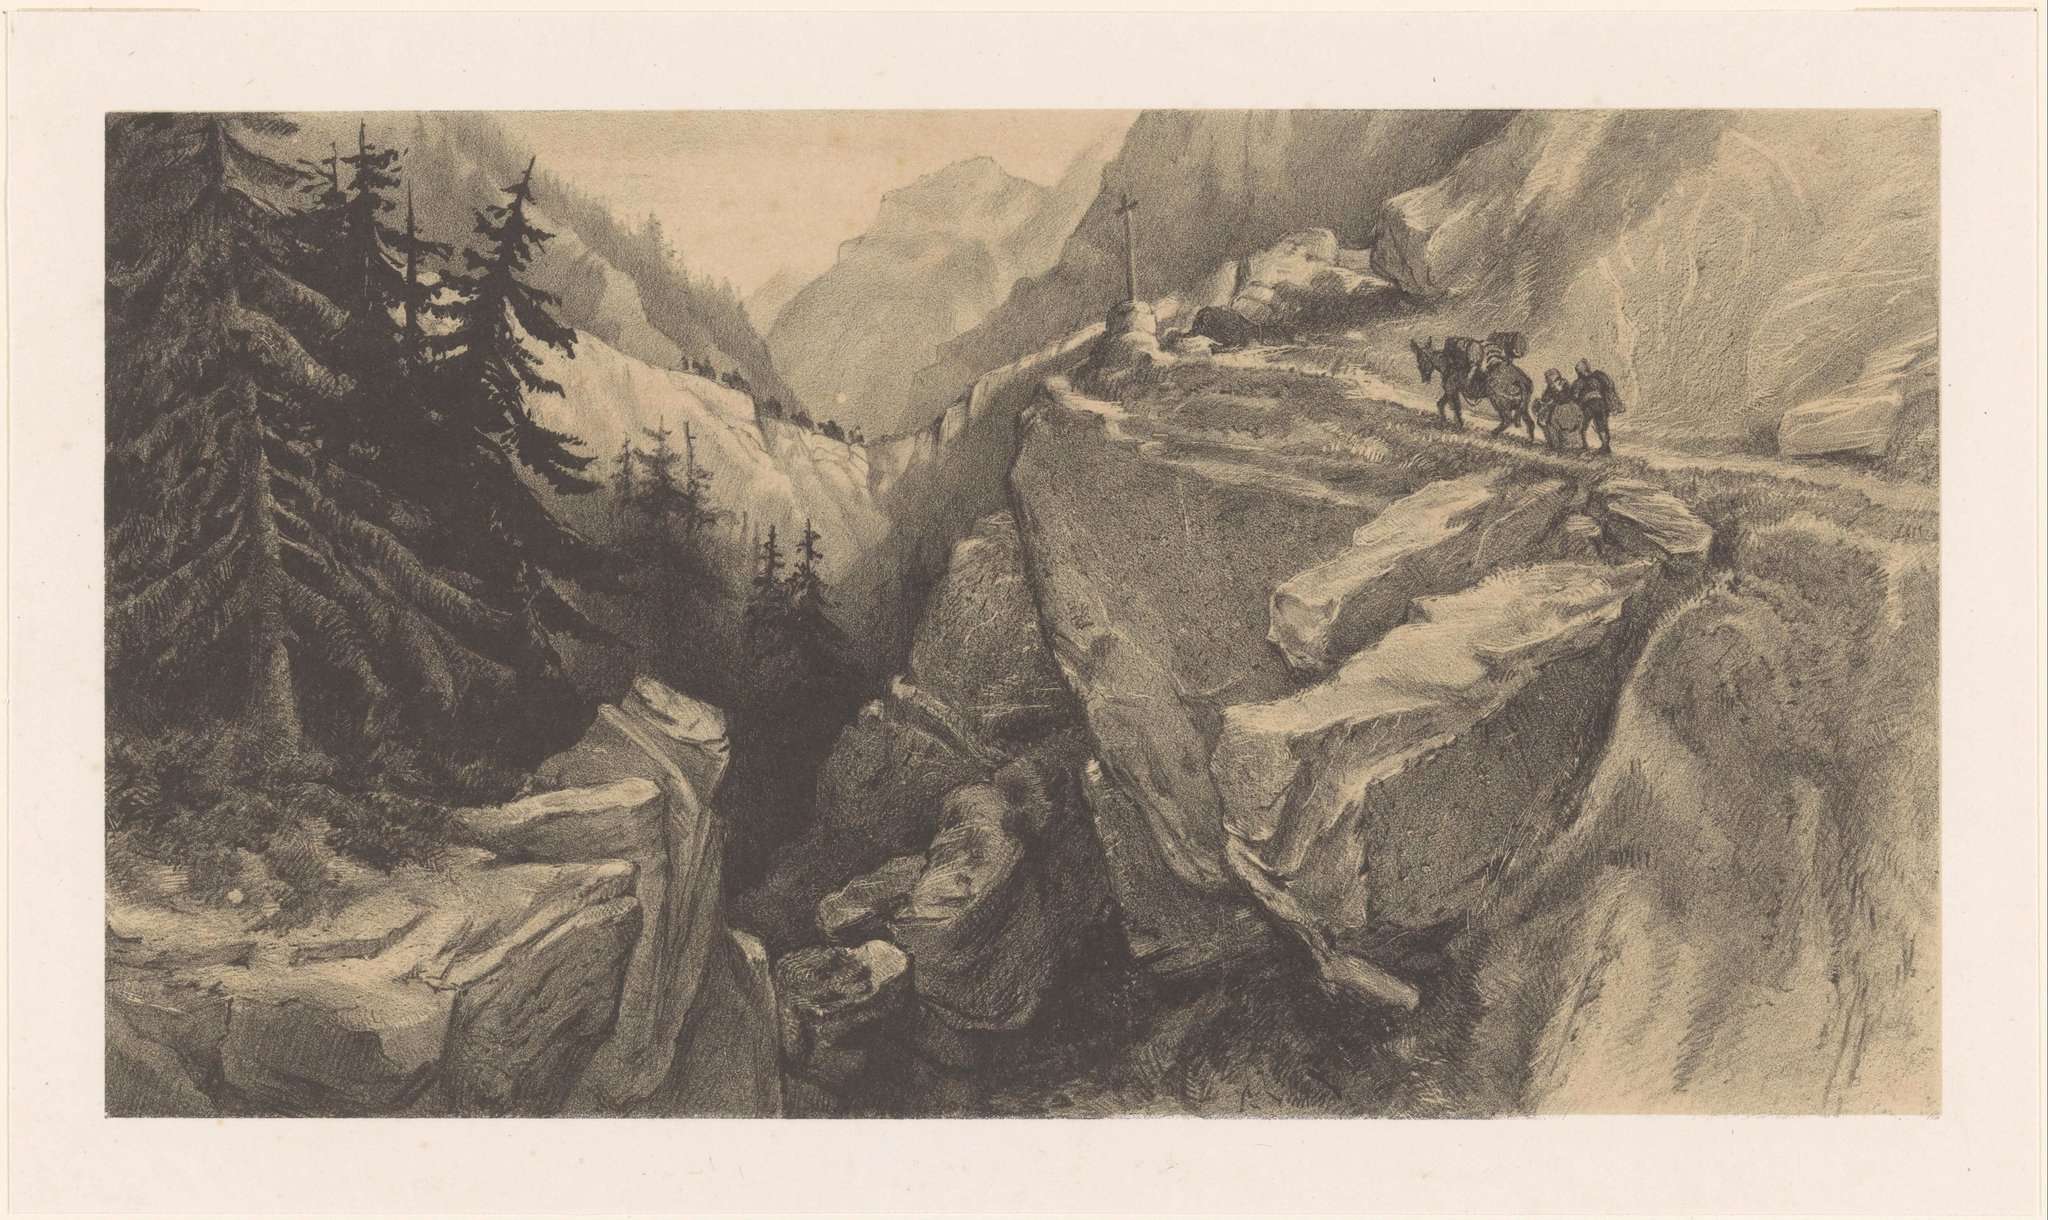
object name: print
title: Berglandschap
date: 1887-1889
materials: paper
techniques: tone lithography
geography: leiden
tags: mule, mountains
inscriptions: collector's mark: Lugt 2233, annotation: ‘copie naar een fransche litho om het steenteekenen te leeren Trap Leiden 1887’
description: Kopie in spiegelbeeld naar een prent van Fortuné Férogio.